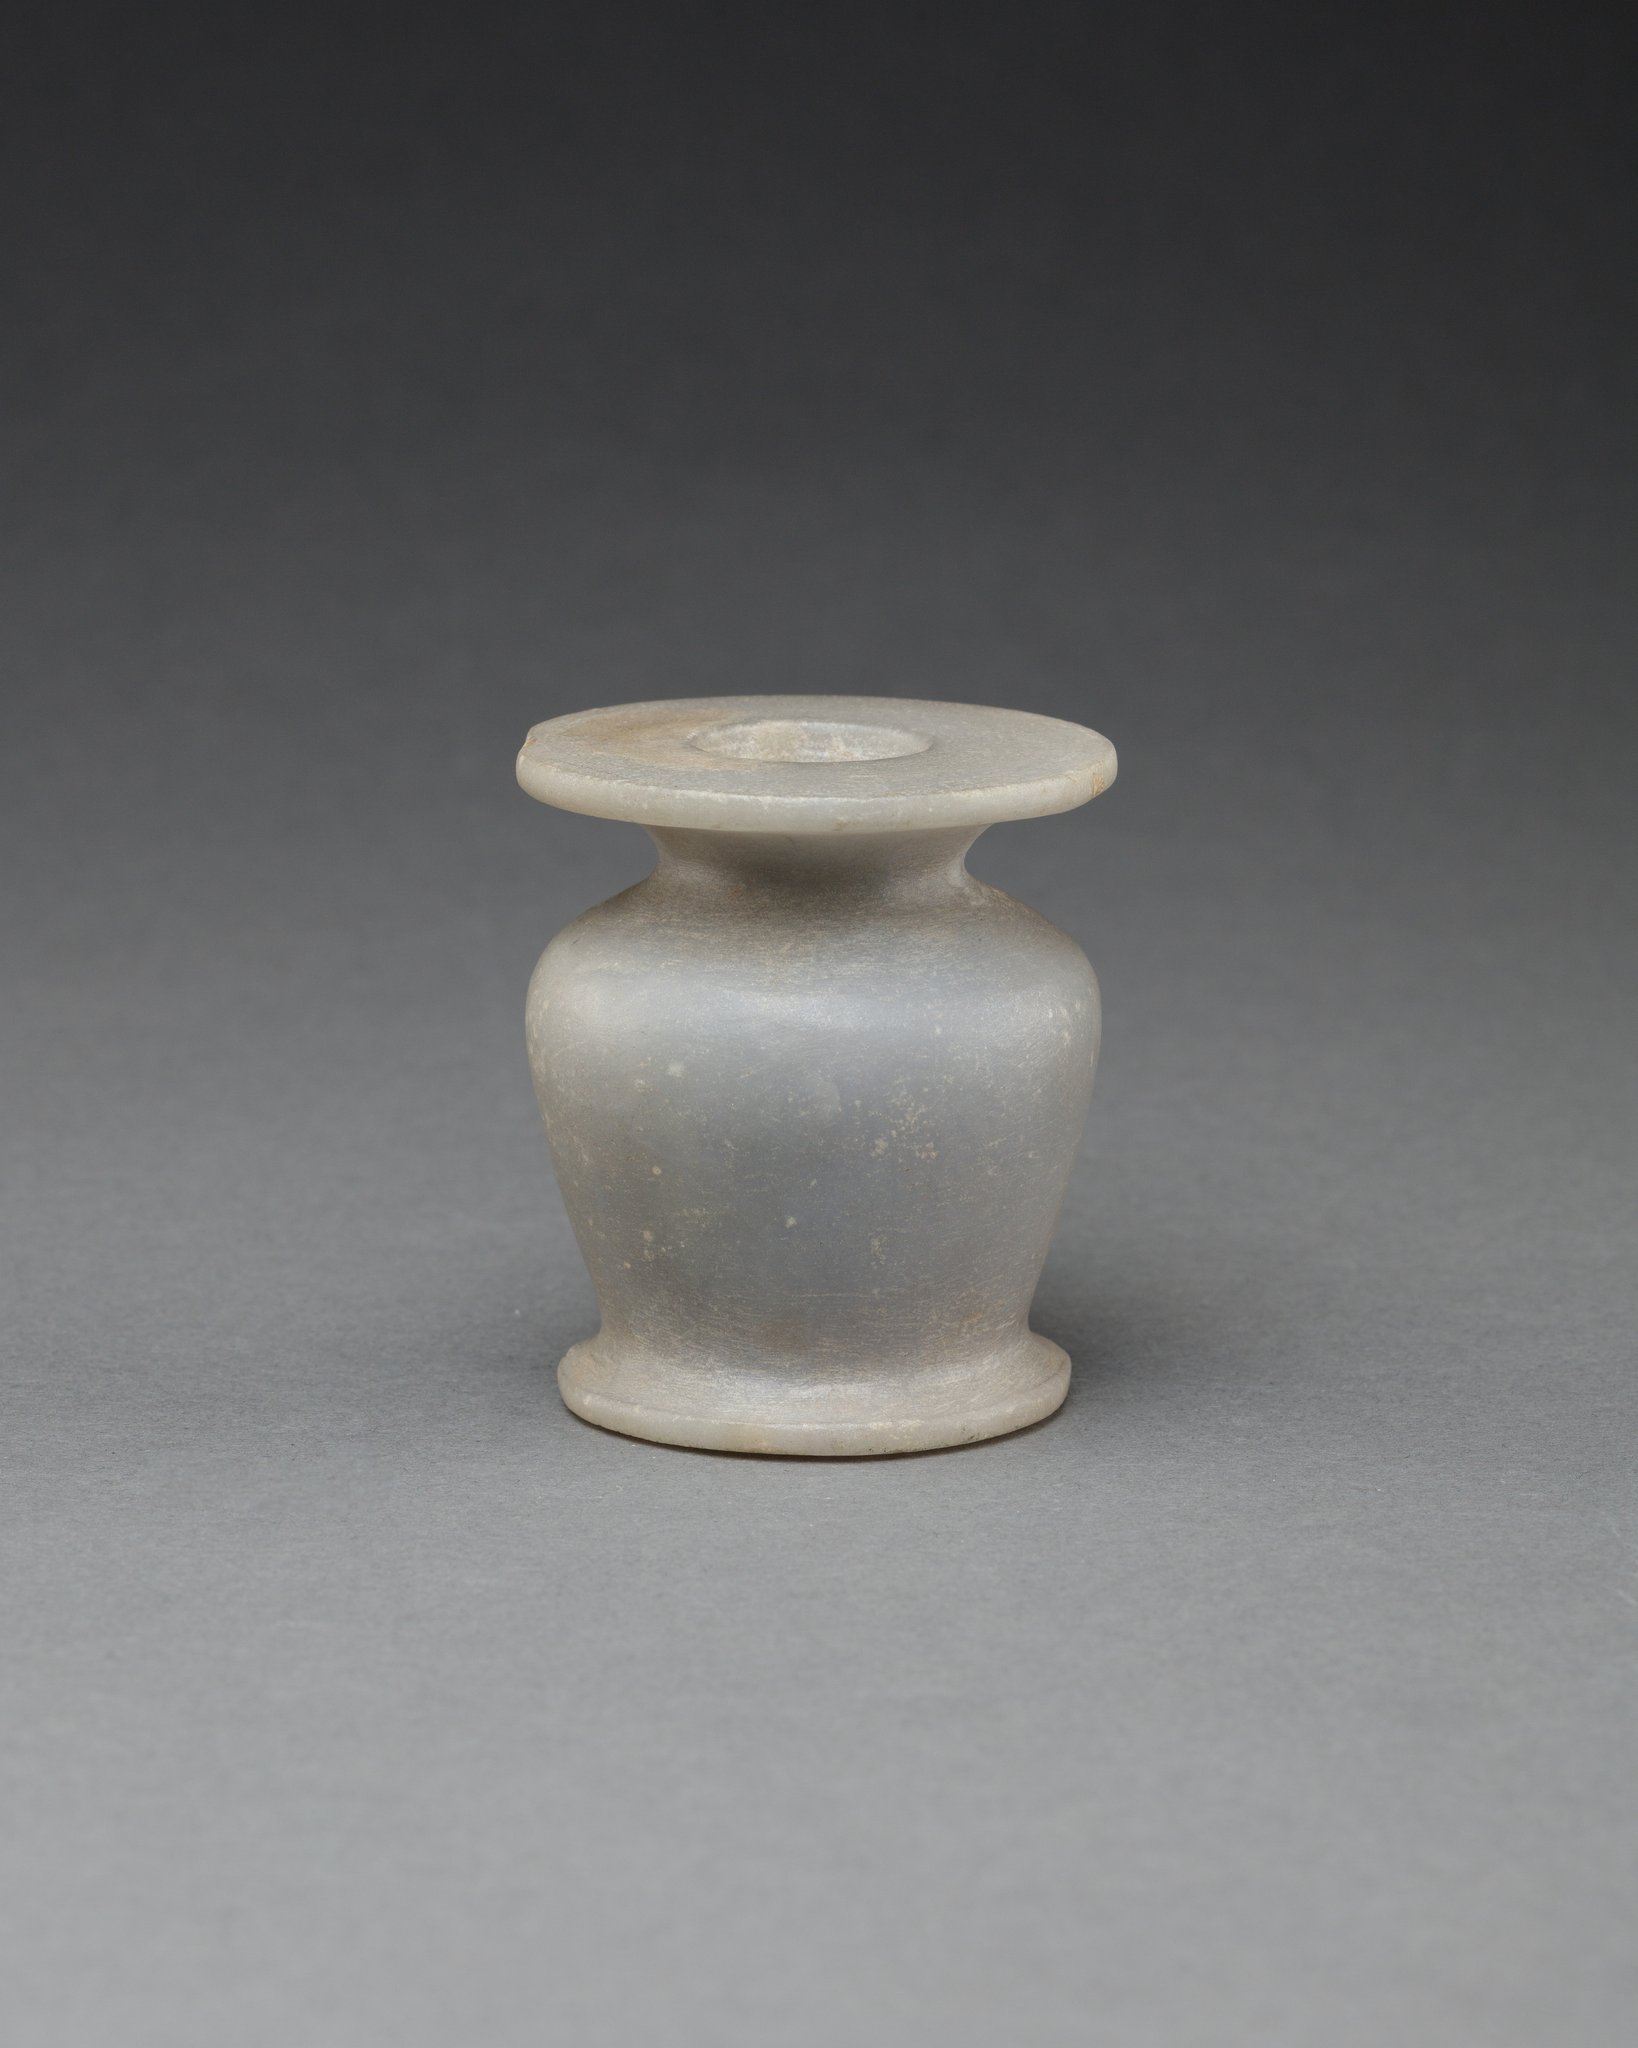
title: Cosmetic Vessel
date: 1980-1550 BCE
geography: egypt